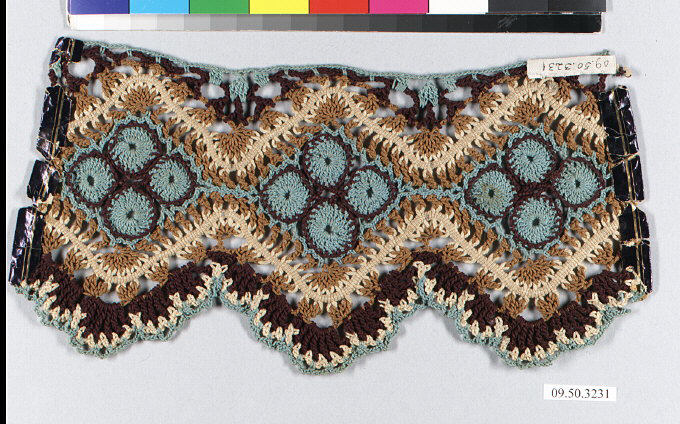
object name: sample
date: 1801-1900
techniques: crochet